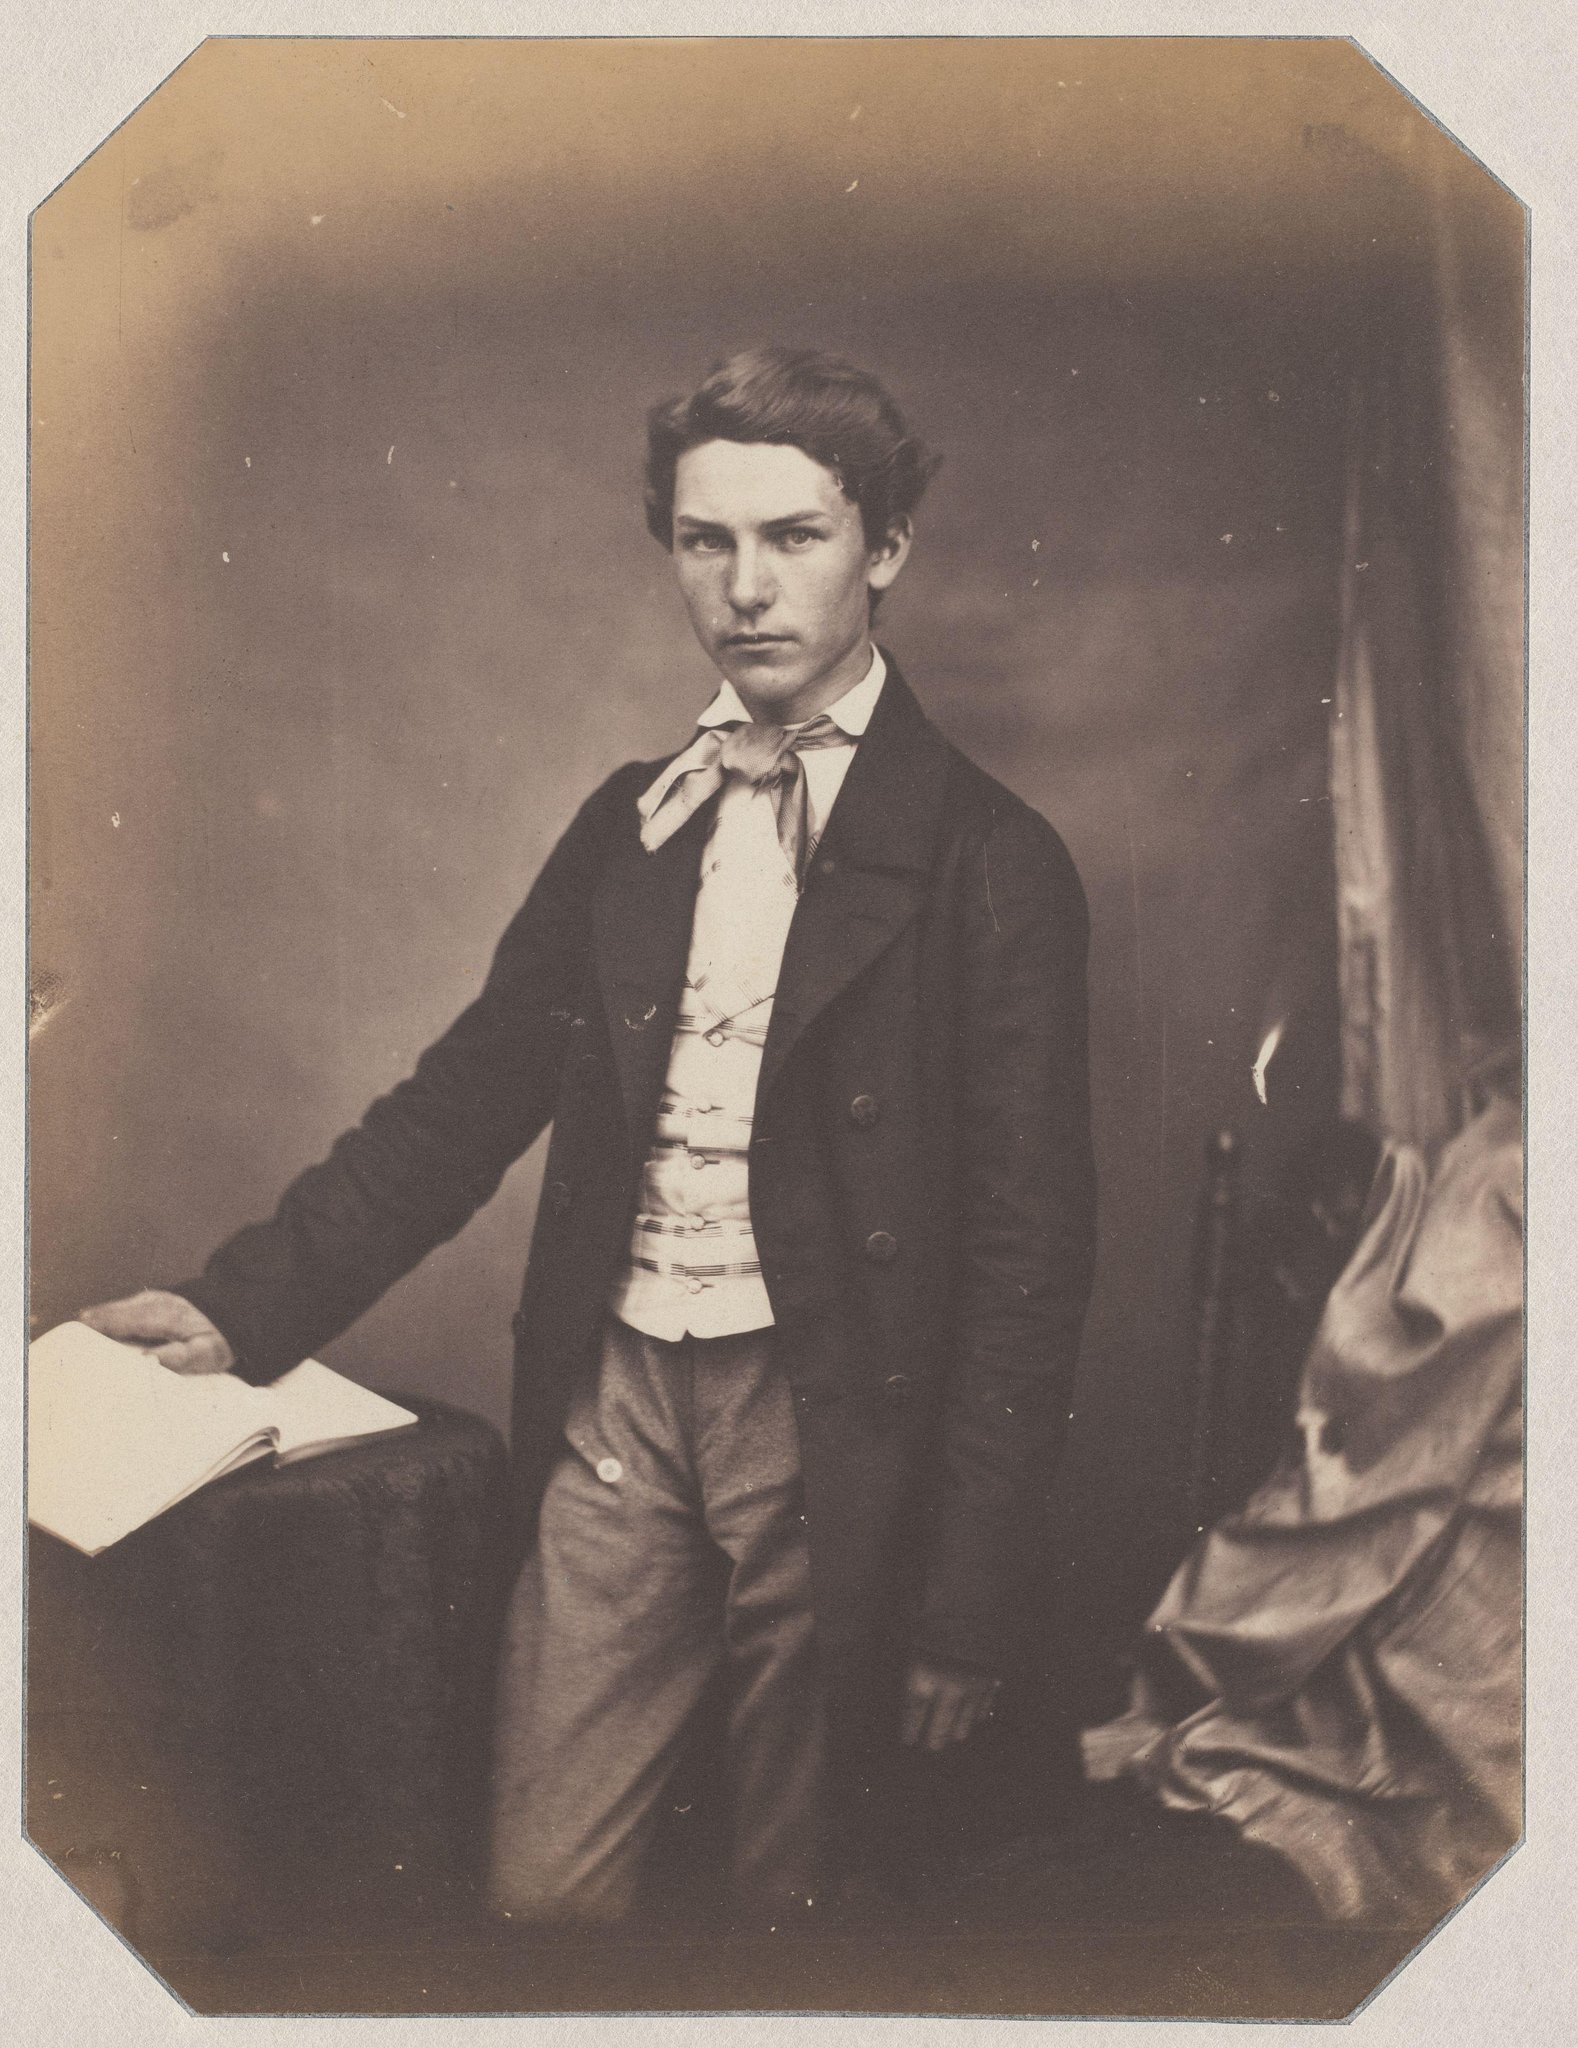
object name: photograph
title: Portret van een onbekende staande jonge man met hand op boek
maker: franz seraph hanfstaengl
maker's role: painter, print maker, printer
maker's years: 1804-1877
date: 1855-1860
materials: paper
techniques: salted paper print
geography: germany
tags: anonymous historical person portrayed